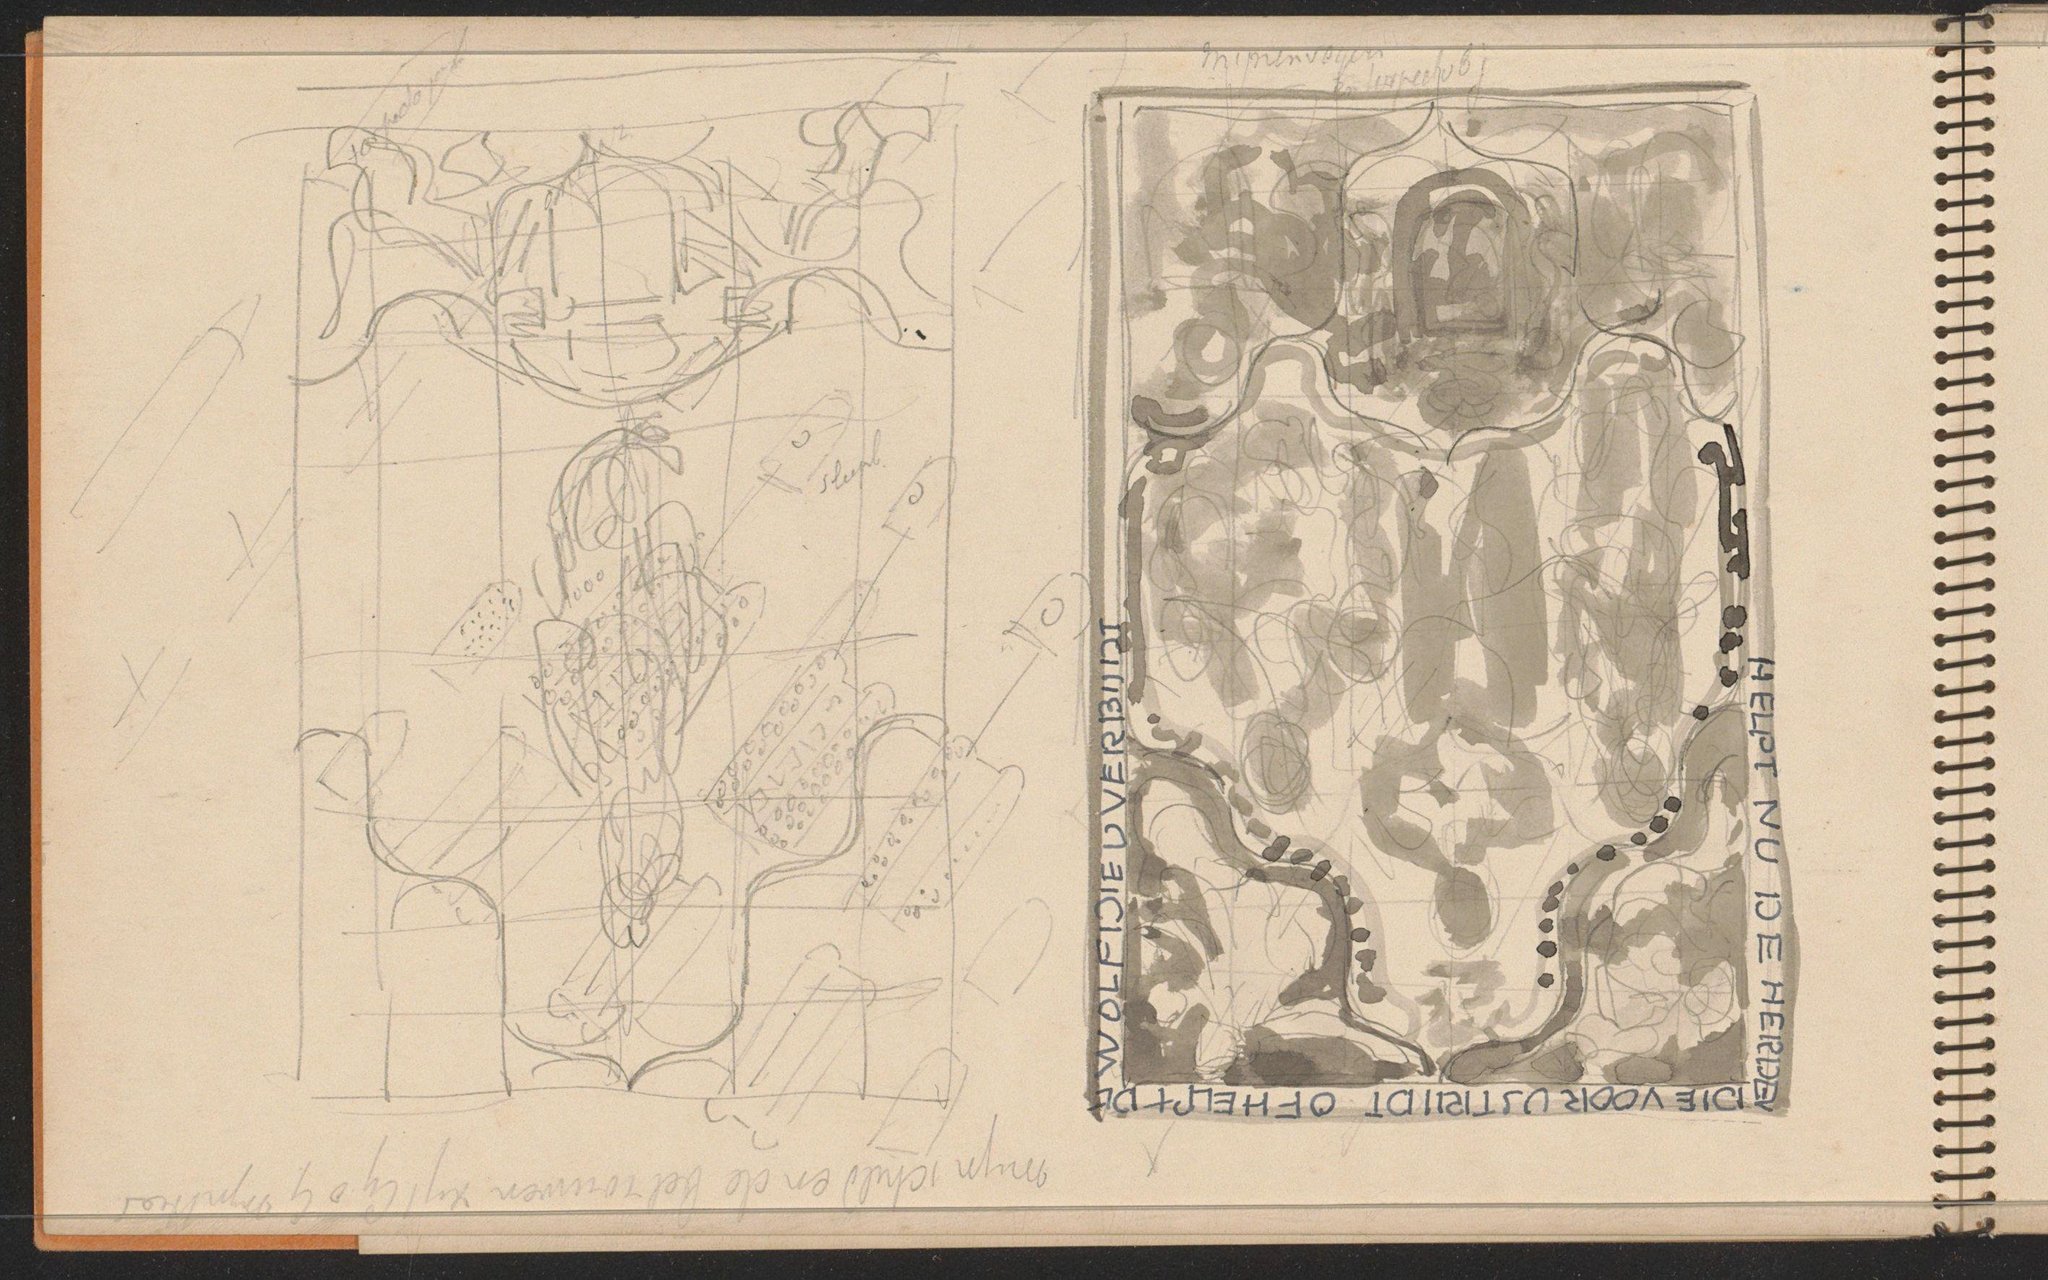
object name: sketchbook leaf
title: Ontwerpen, vermoedelijk voor posters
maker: carel adolph lion cachet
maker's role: draughtsman, print maker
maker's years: 1864-1945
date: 1928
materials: ink, paper, pencil, watercolor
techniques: brush, pen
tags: poster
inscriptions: annotation: ‘HELPT NU DE HERDER/ DIE VOOR U STRIJDT/ OF HELPT DE WOLF DIE U VERBIJDT/ mijn schild en de bel rouwen zij[...] mijn Heer/ mijnenveger/ en [...]’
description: Blad 2 verso uit een schetsboek met 12 bladen.